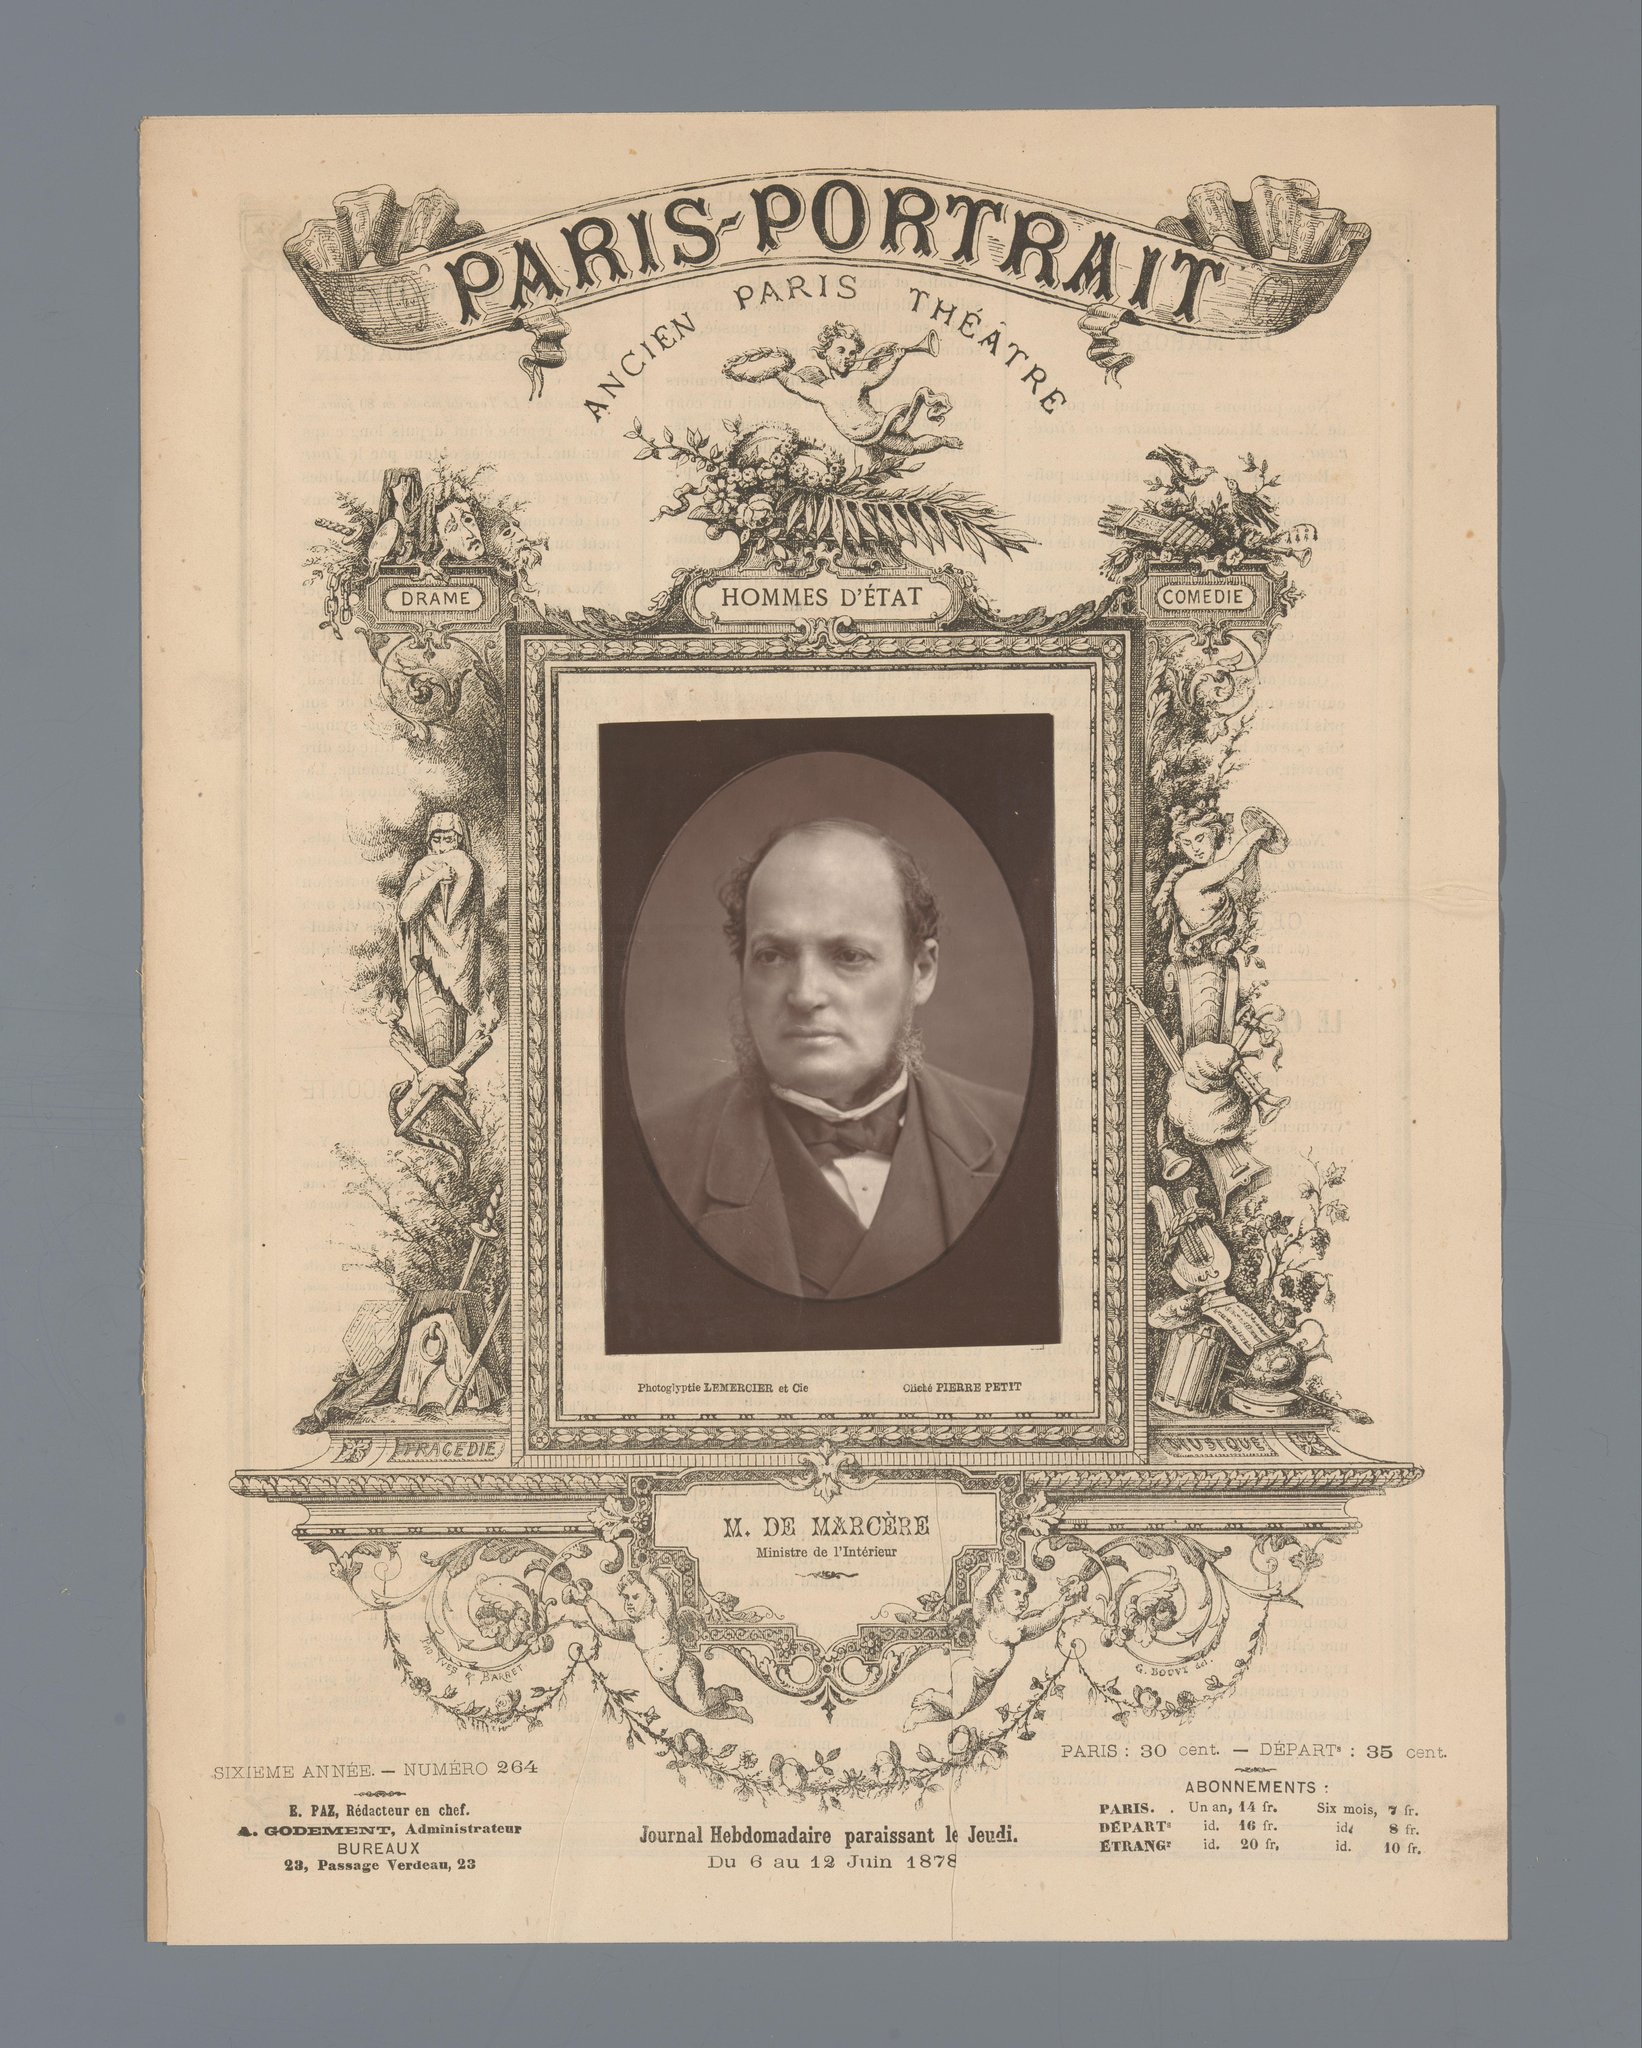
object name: photomechanical print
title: Portret van Émile de Marcère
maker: pierre petit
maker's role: fotograaf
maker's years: 1832-1909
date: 1873-1880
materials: paper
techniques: woodburytype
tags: politician, historical persons, politician, e.g. party leader